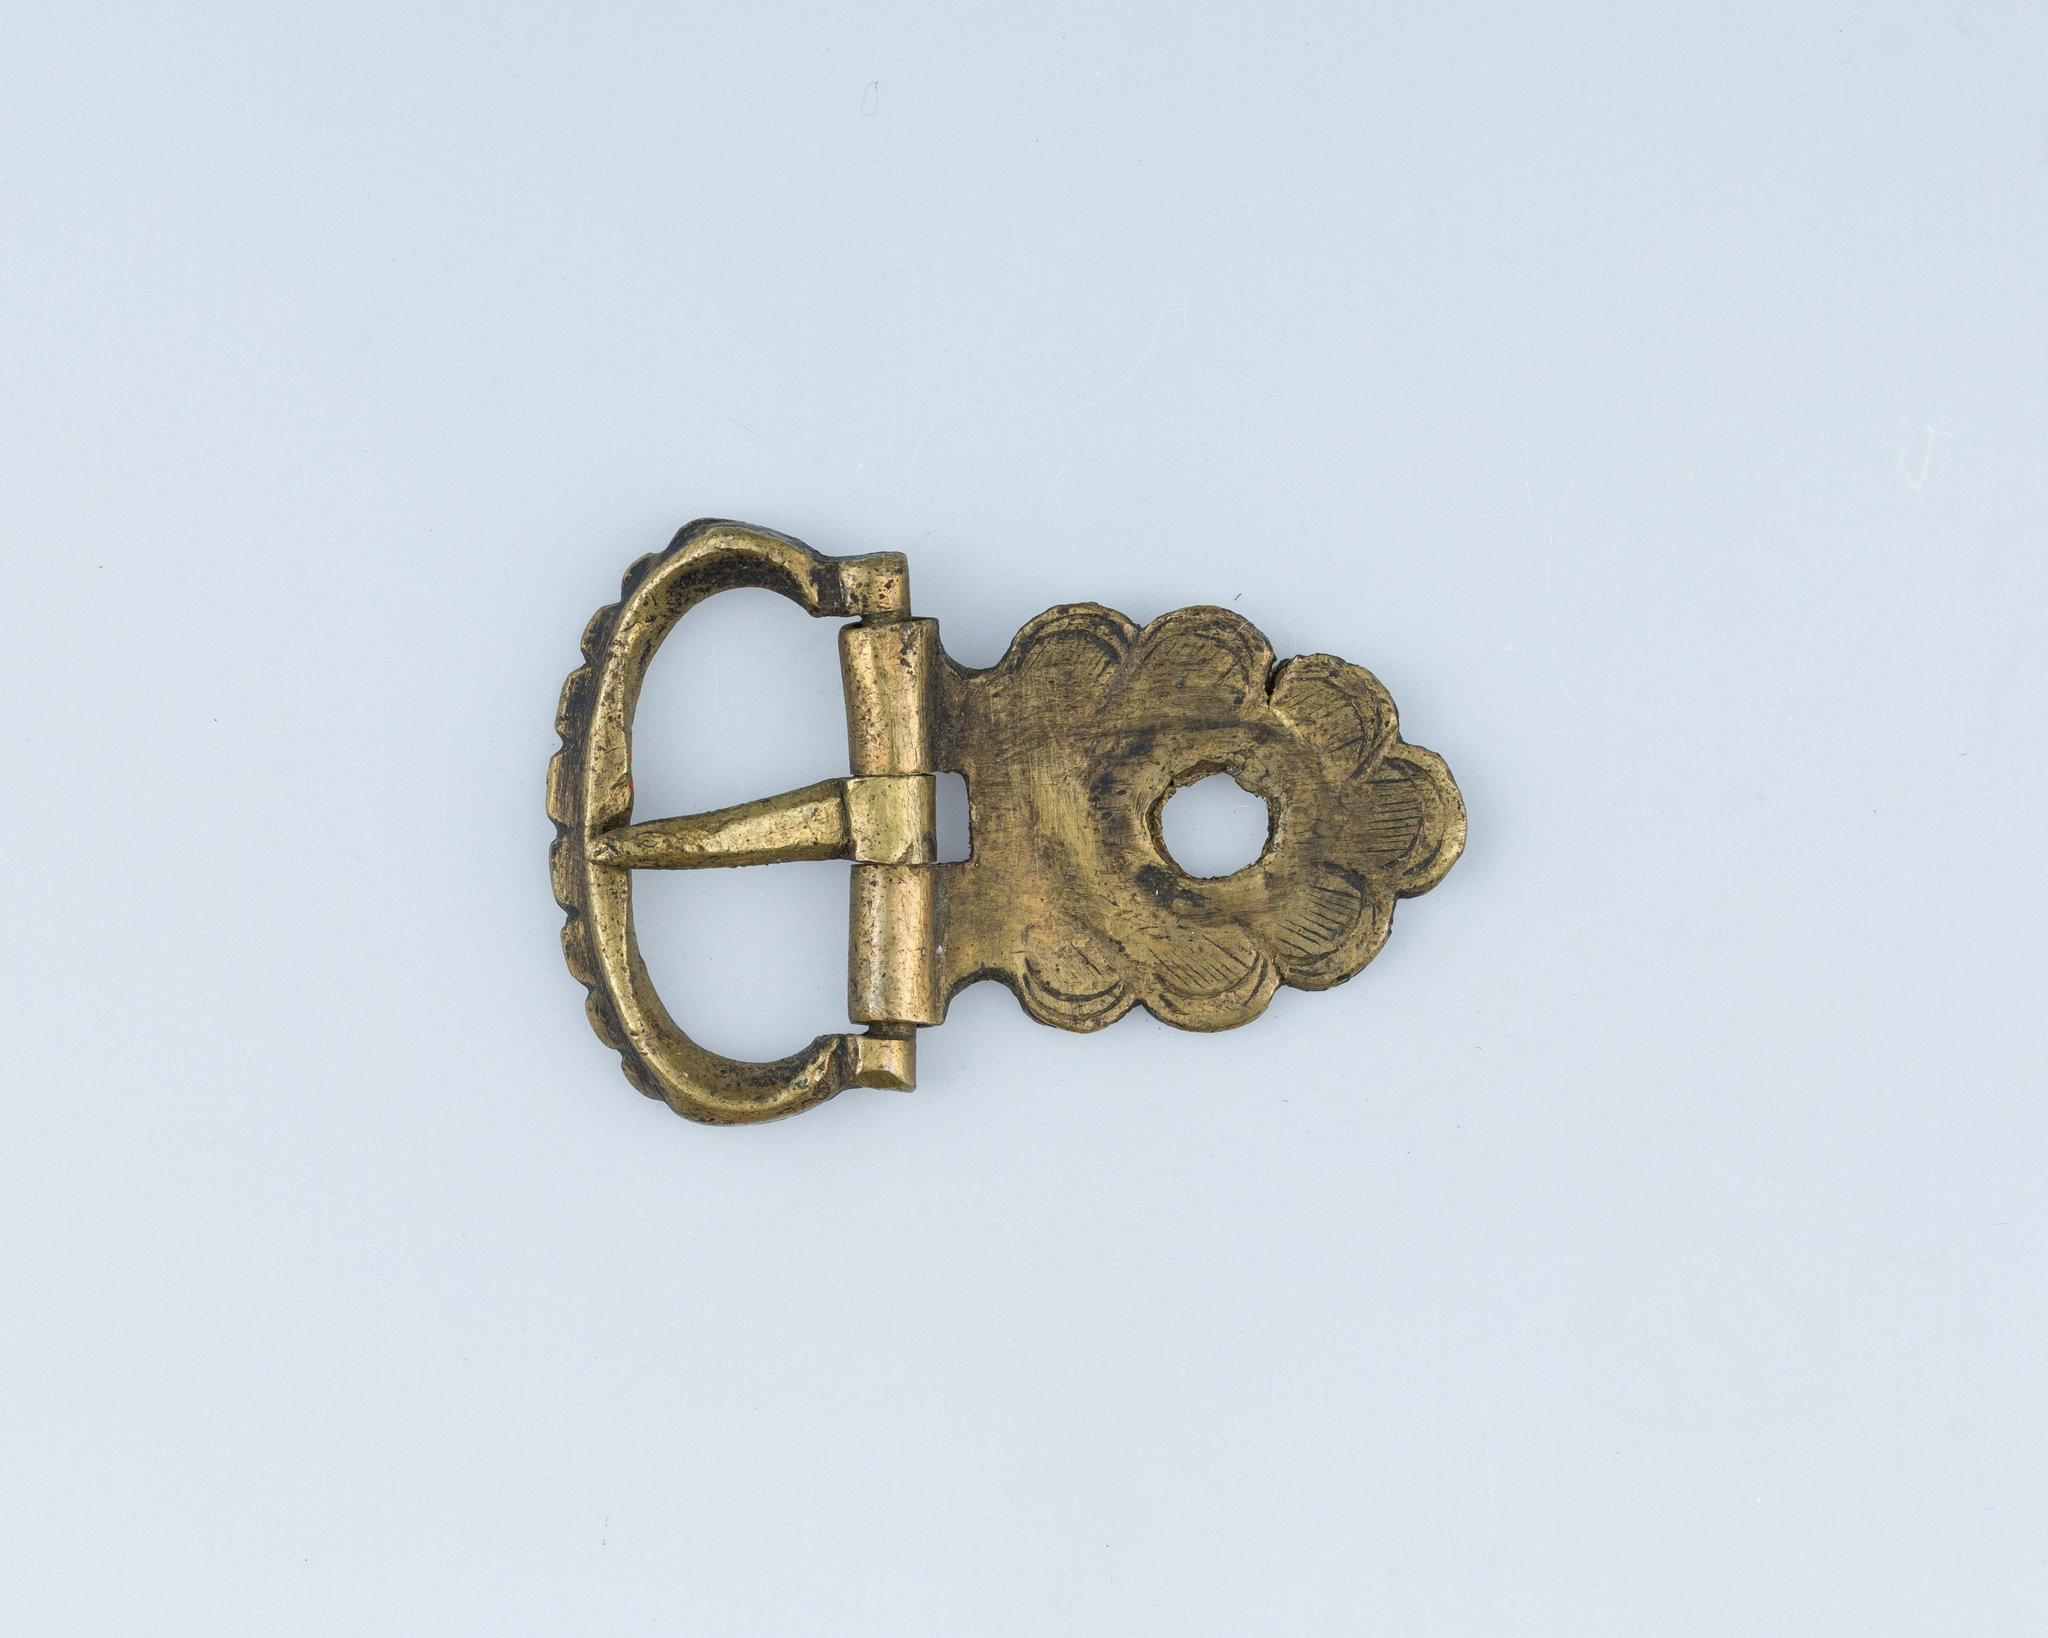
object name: buckle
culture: german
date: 1500-1520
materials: brass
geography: germany